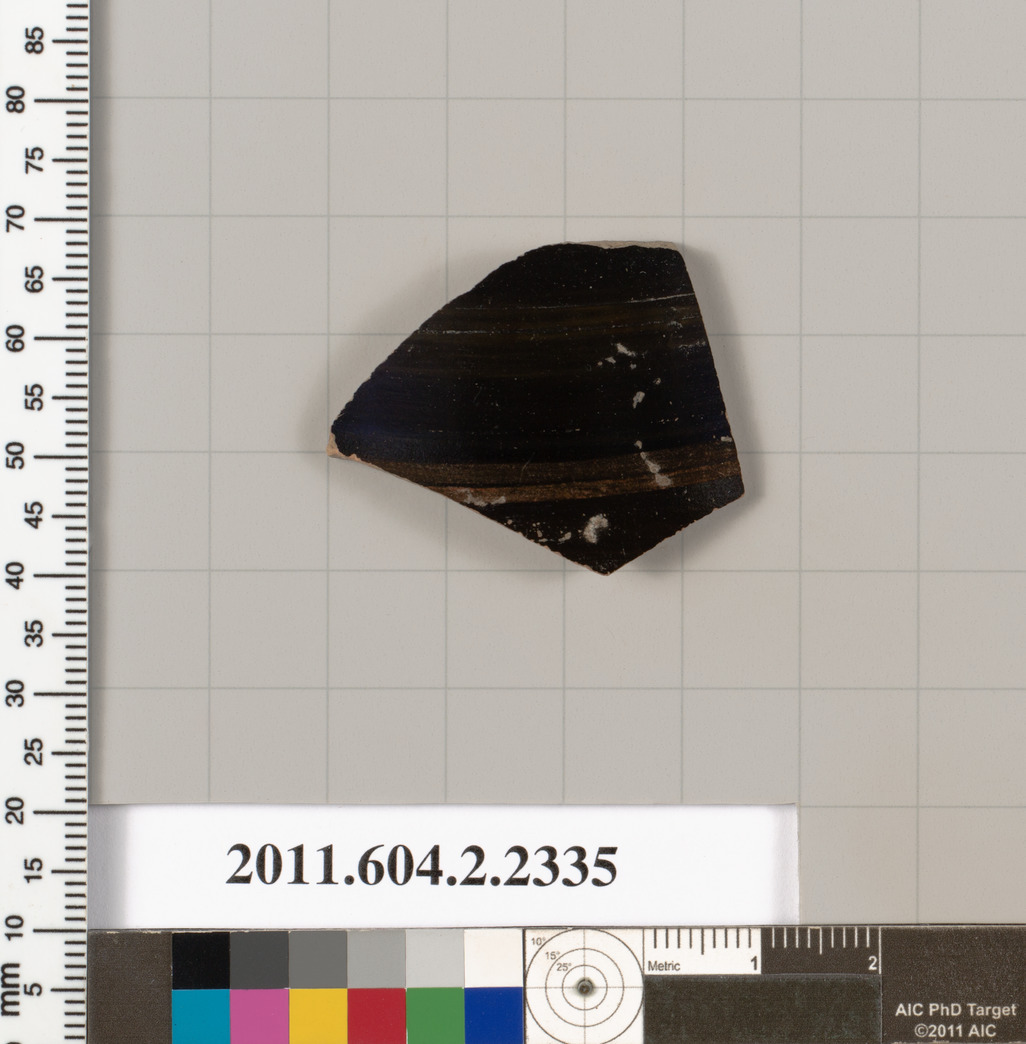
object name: skyphos fragment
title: Terracotta fragment of a skyphos (deep drinking cup)?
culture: greek, attic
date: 467-435 BCE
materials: terracotta